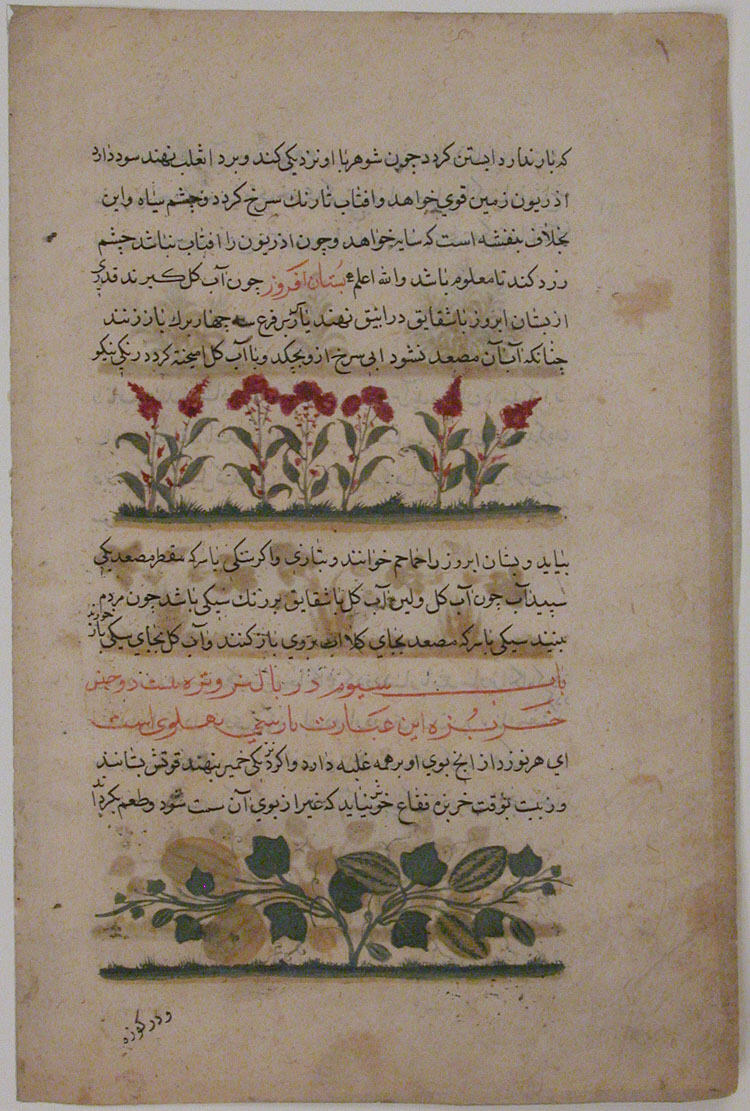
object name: folio from an illustrated manuscript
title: "Purple Amaranth and Watermelon", Folio from a Dispersed Nuzhatnama-i ‘Ala’i of Shahmardan ibn Abi’l Khayr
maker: shamardan ibn abi 'l khayr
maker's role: author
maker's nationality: iranian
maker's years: 1075-1125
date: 1401-1433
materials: gold, ink, paper, watercolor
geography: iran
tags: fruit,flowers